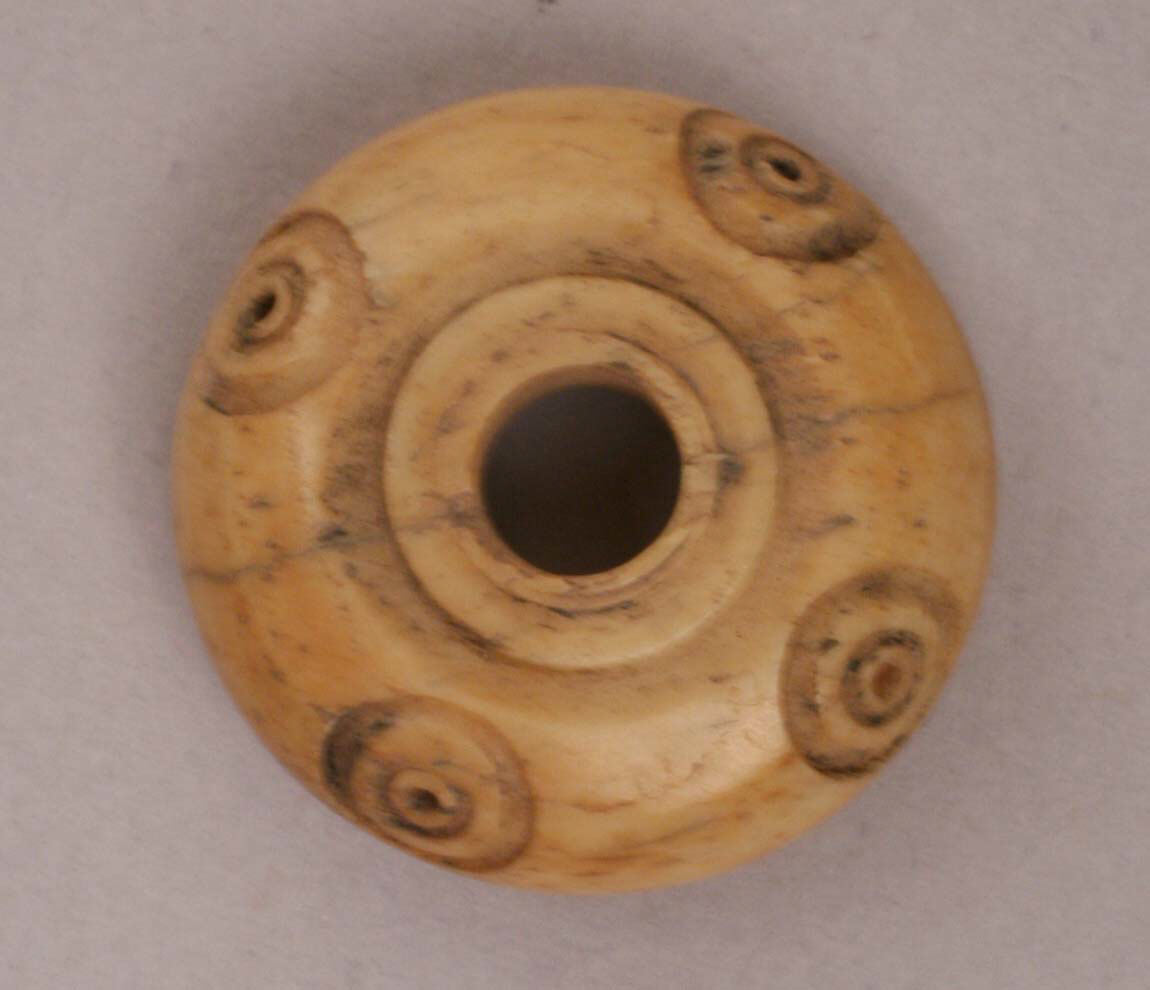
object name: button or bead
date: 801-1000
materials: bone, paint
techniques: incising, inlay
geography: iran